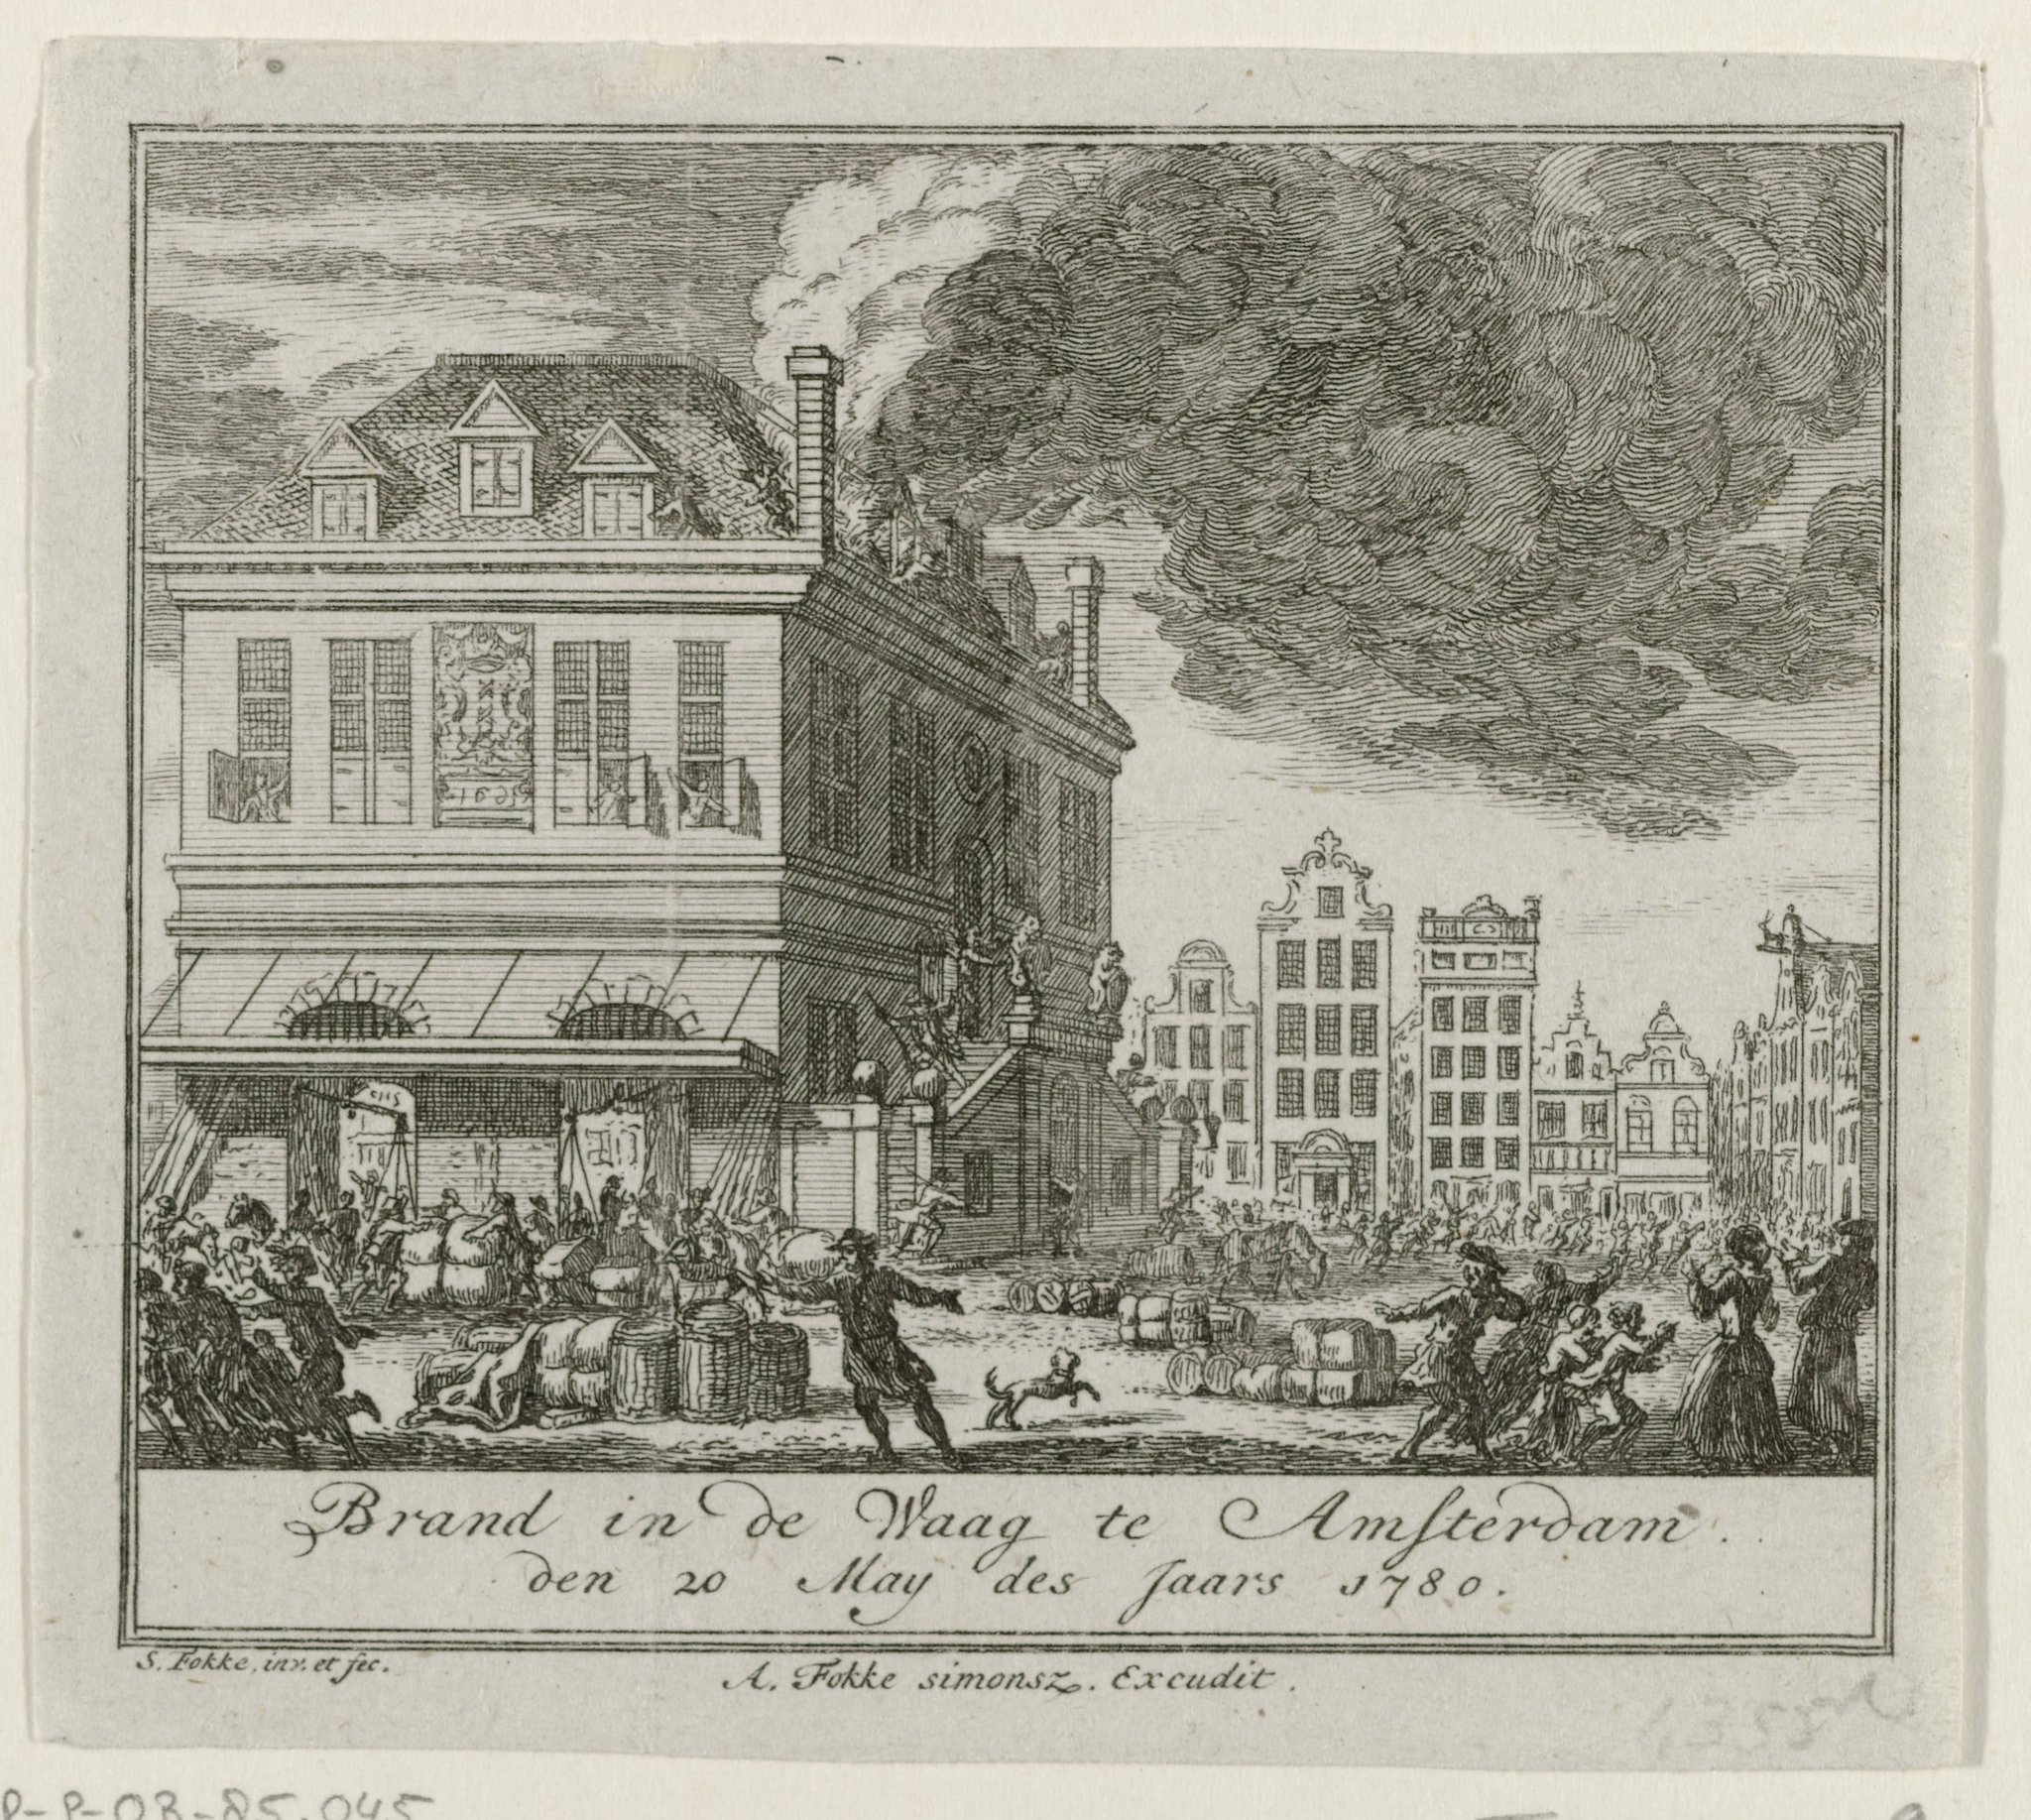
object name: print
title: Brand in de Waag te Amsterdam, 1779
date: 1783-1784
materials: paper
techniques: etching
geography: northern netherlands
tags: on fire, ablaze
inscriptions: collector's mark: Lugt 2228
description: Gebruikt als illustratie in: Arend Fokke Simonsz. De vaderlandsche historie in themata. Amsterdam: Arend Fokke Simonsz., edities tussen 1783-ca. 1792.